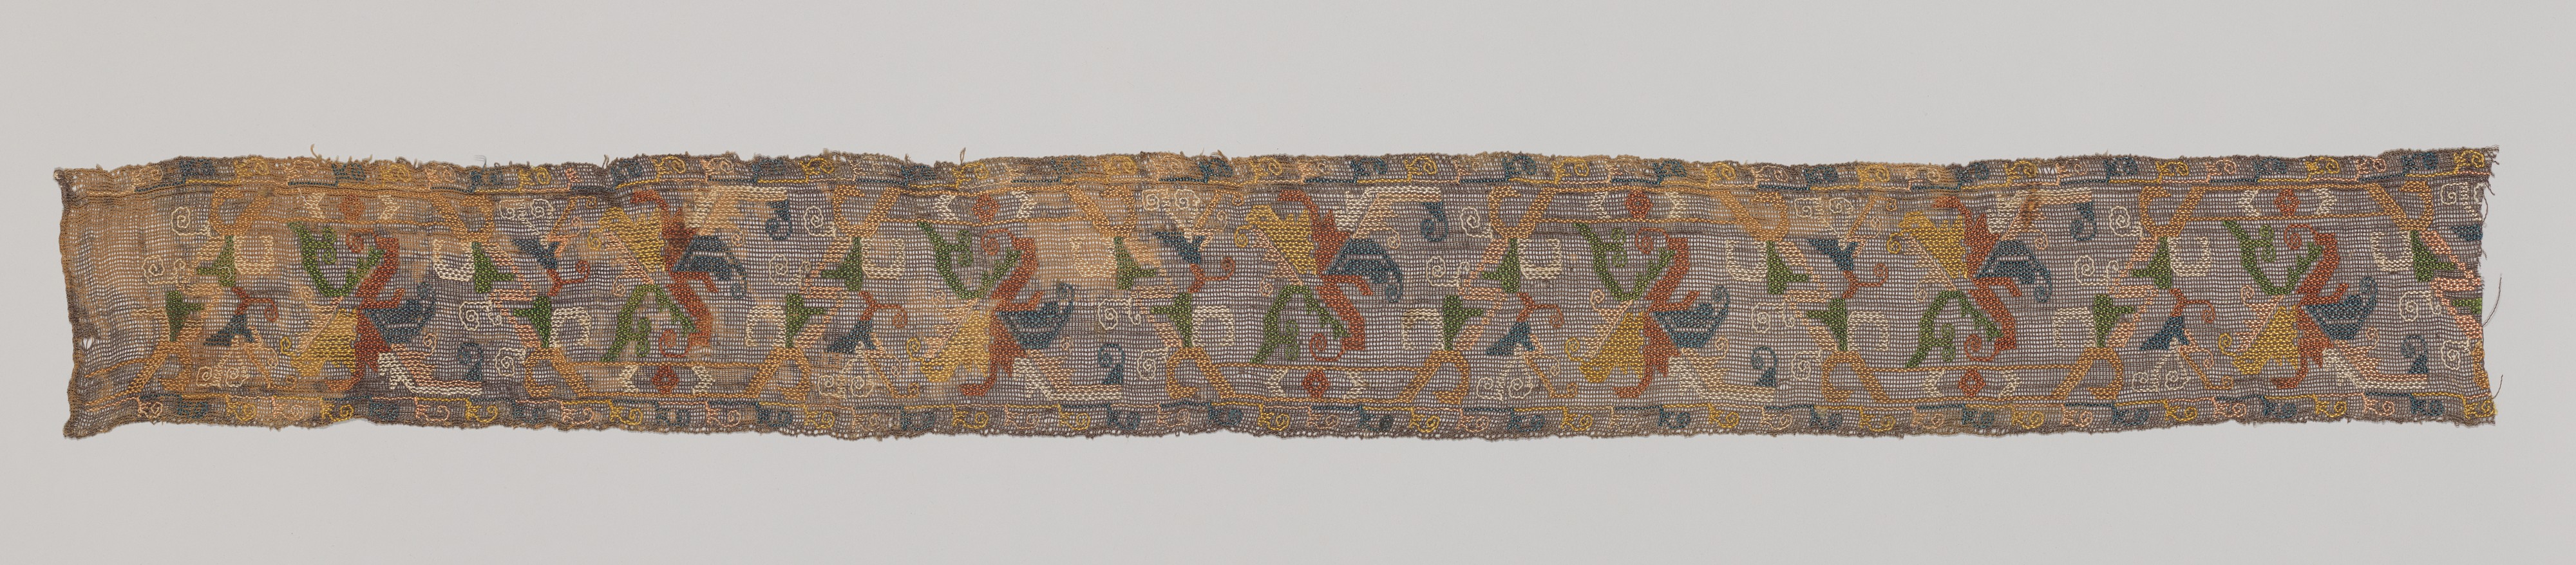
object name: border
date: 1501-1600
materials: silk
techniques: embroidery